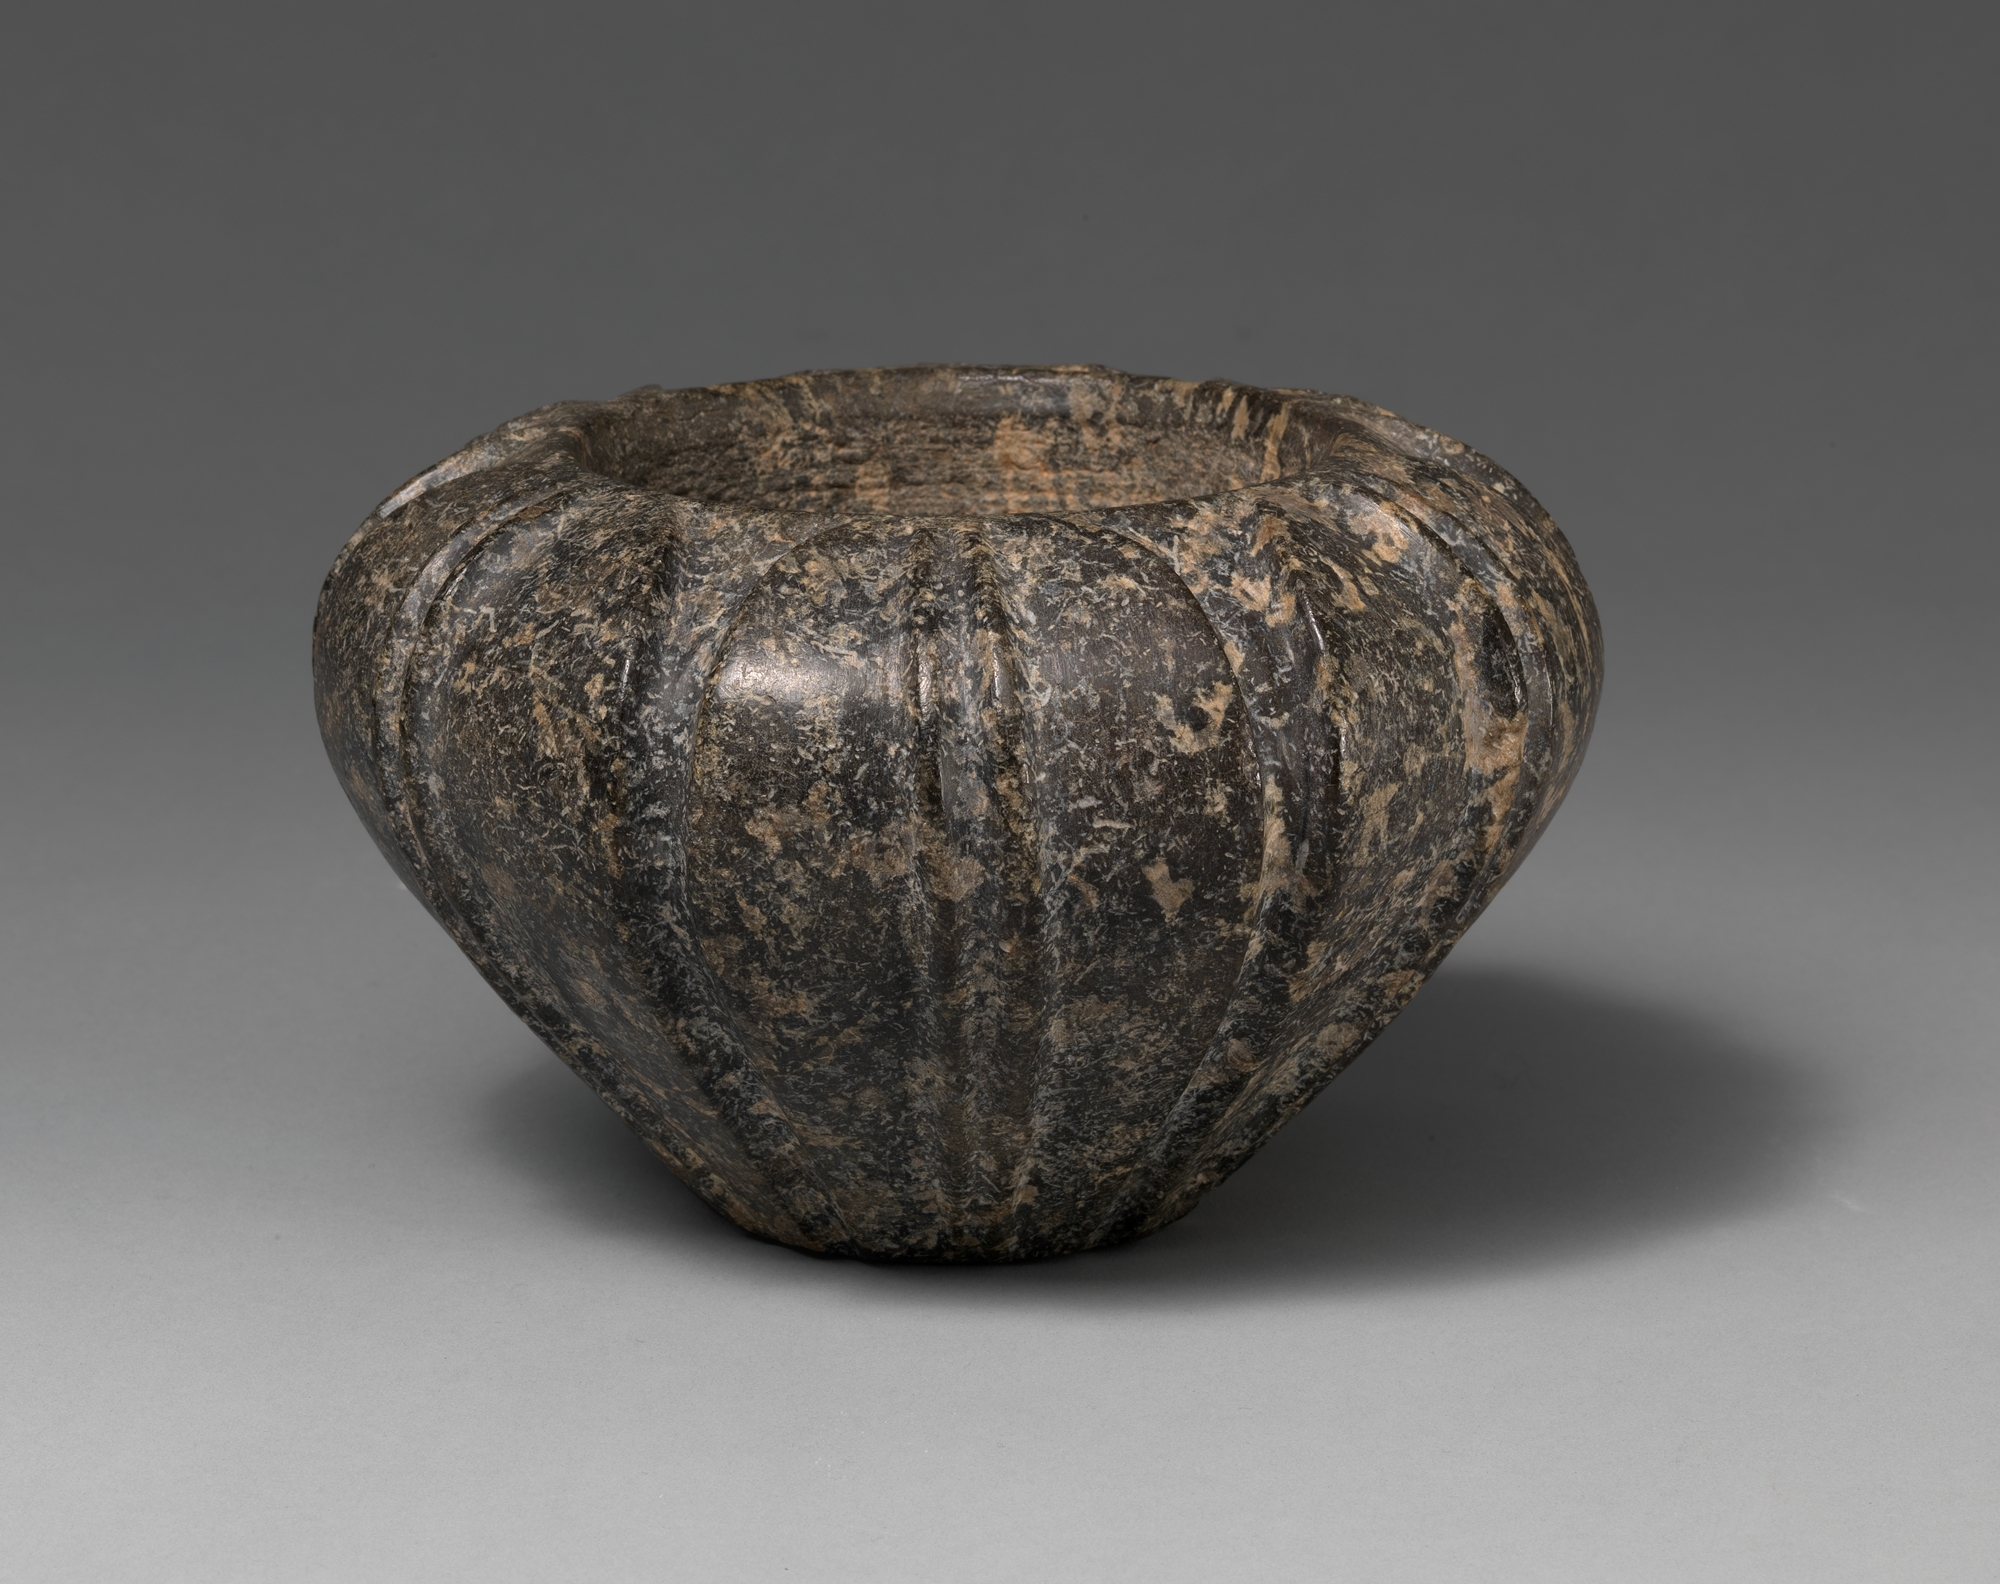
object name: blossom bowl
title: Serpentine blossom bowl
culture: minoan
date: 1600-1450 BCE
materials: stone